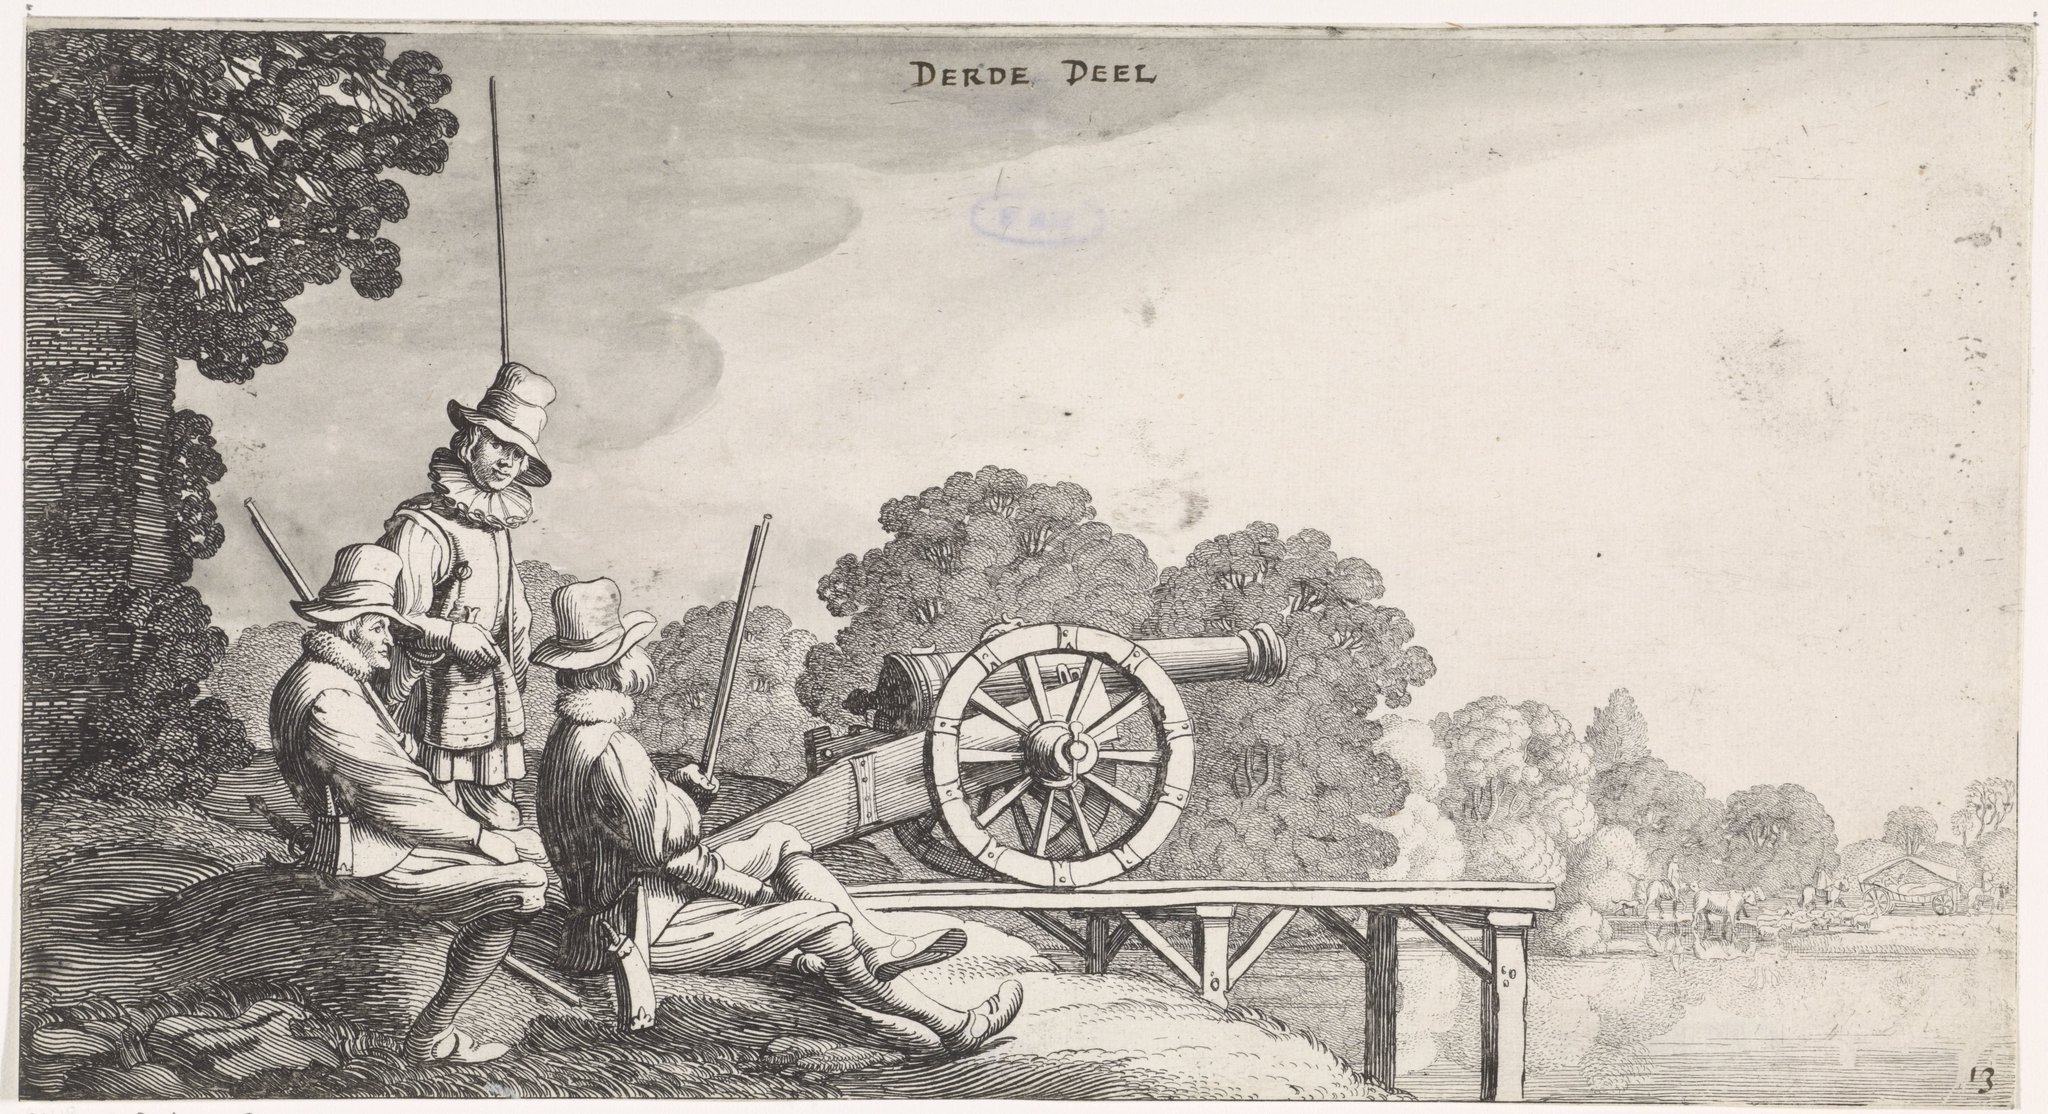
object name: print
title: Playsante lantschappen ende vermakelycke gesichten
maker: jan van de velde (ii)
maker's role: draughtsman, painter, print maker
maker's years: 1593-1641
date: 1639-1641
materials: ink, paper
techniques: brush, etching, pen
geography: northern netherlands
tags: firearms: cannon, the soldier; the soldier's life, pier, quay, wharf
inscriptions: inscription: ‘Derde Deel’, collector's mark: Lugt 1120, collector's mark: Lugt 2228, number: ‘13’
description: Drie soldaten bij een kanon op een steiger aan een rivier. Dertiende prent van een serie met 36 prenten van landschappen, verdeeld over zes delen.